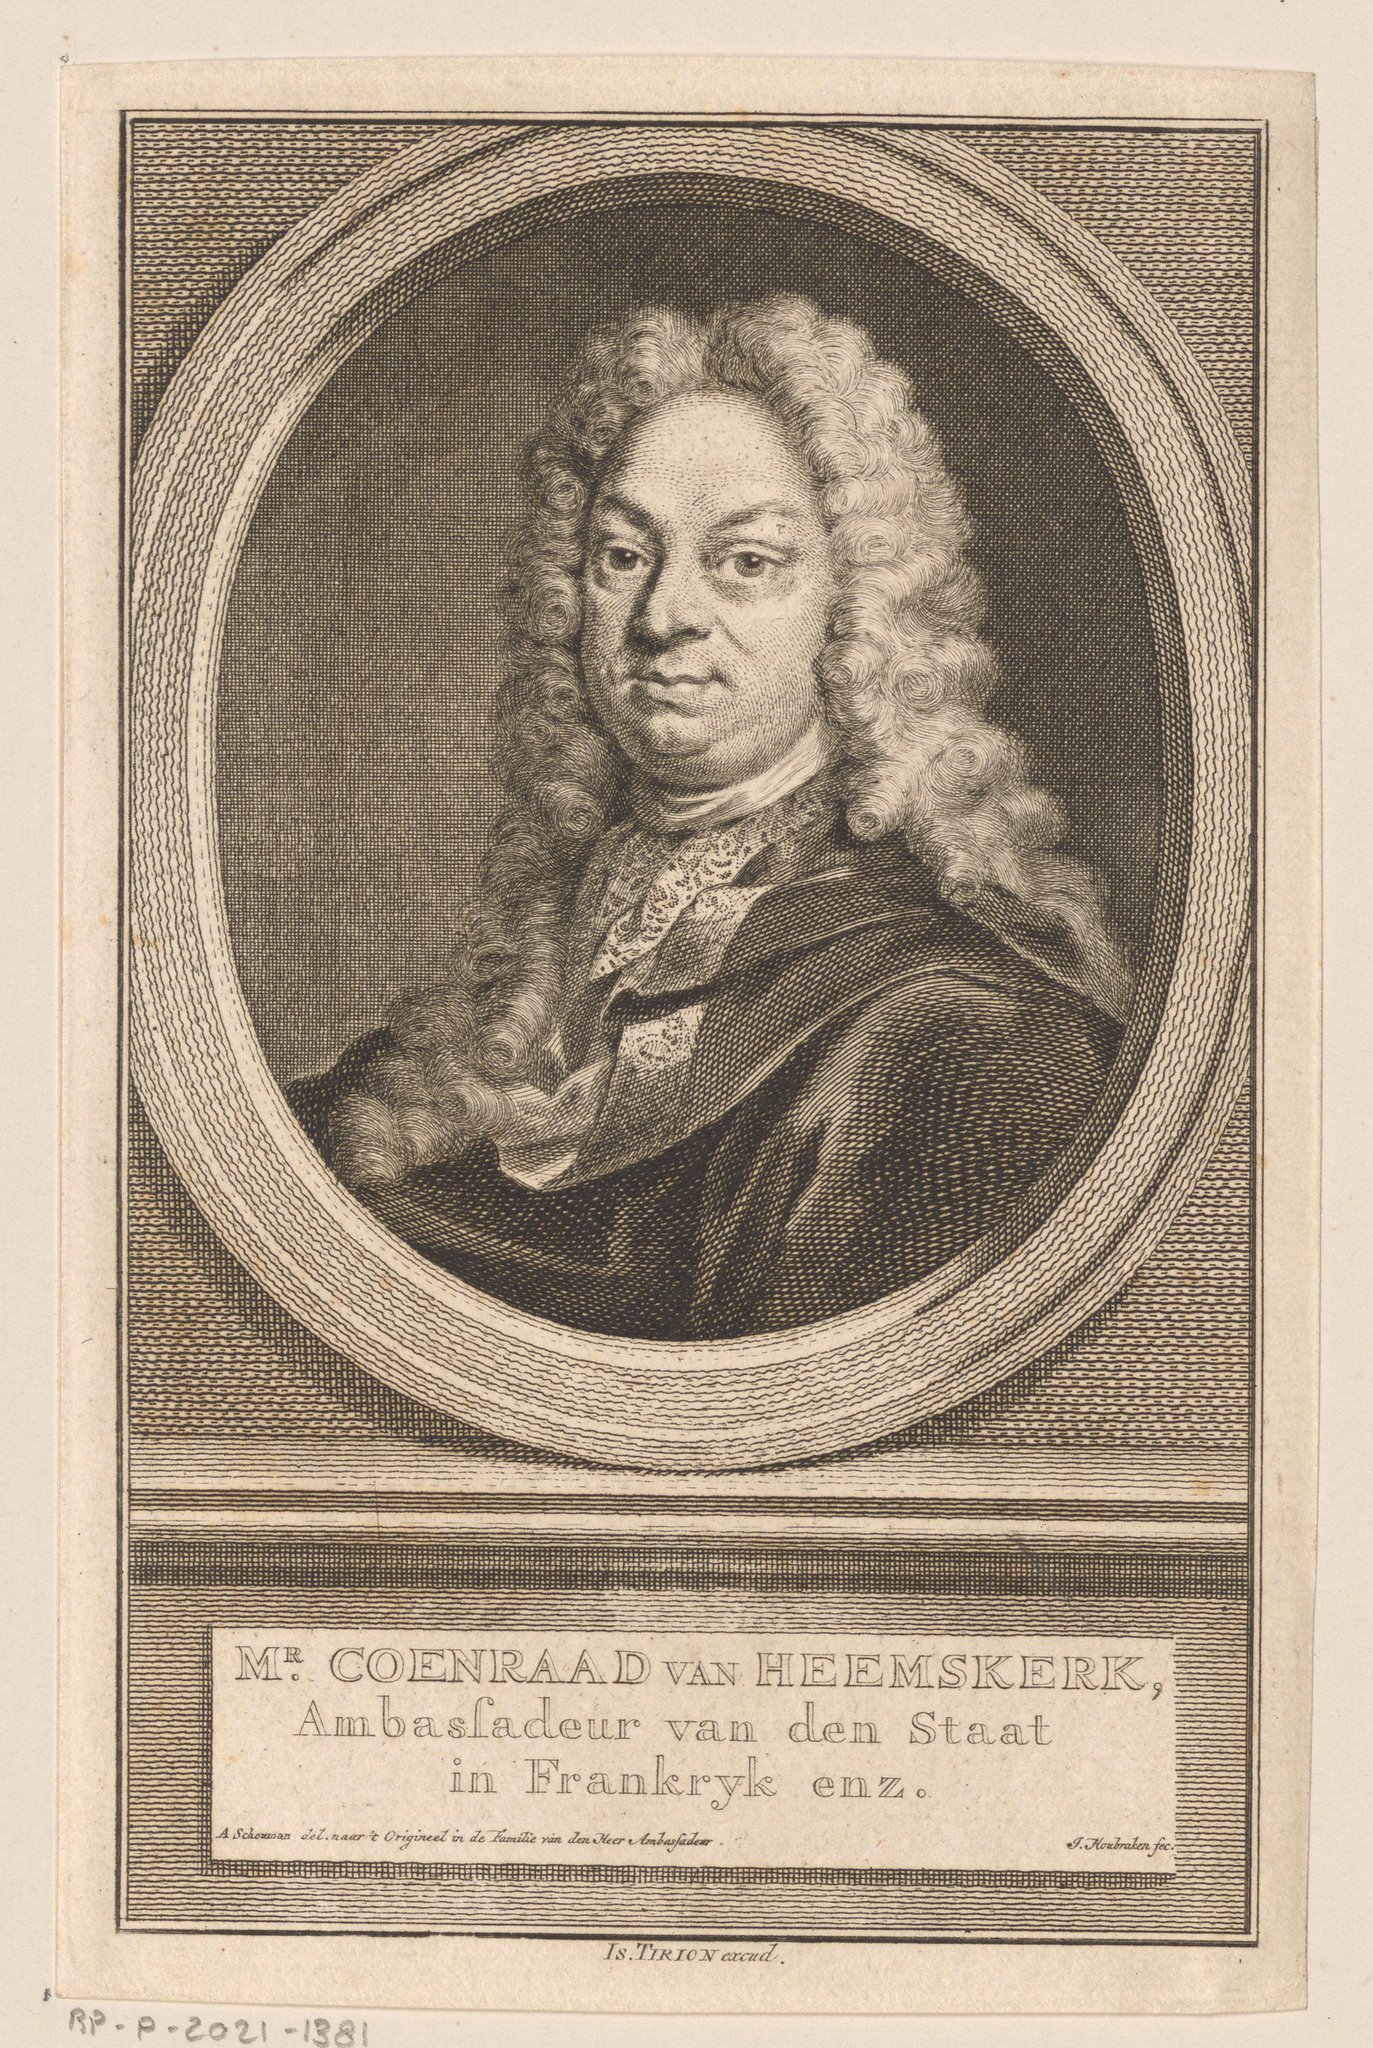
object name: book illustration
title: Portret van Coenraad van Heemskerk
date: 1749-1759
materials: paper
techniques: engraving, etching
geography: amsterdam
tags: the hague, historical persons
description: Prent uit: Wagenaar, Jan. Vaderlandsche historie, vervattende de geschiedenissen der nu Vereenigde Nederlanden (...). 21 dln. Amsterdam: Isaak Tirion, 1749-1759. Prent ook gebruikt in latere edities van dit werk.